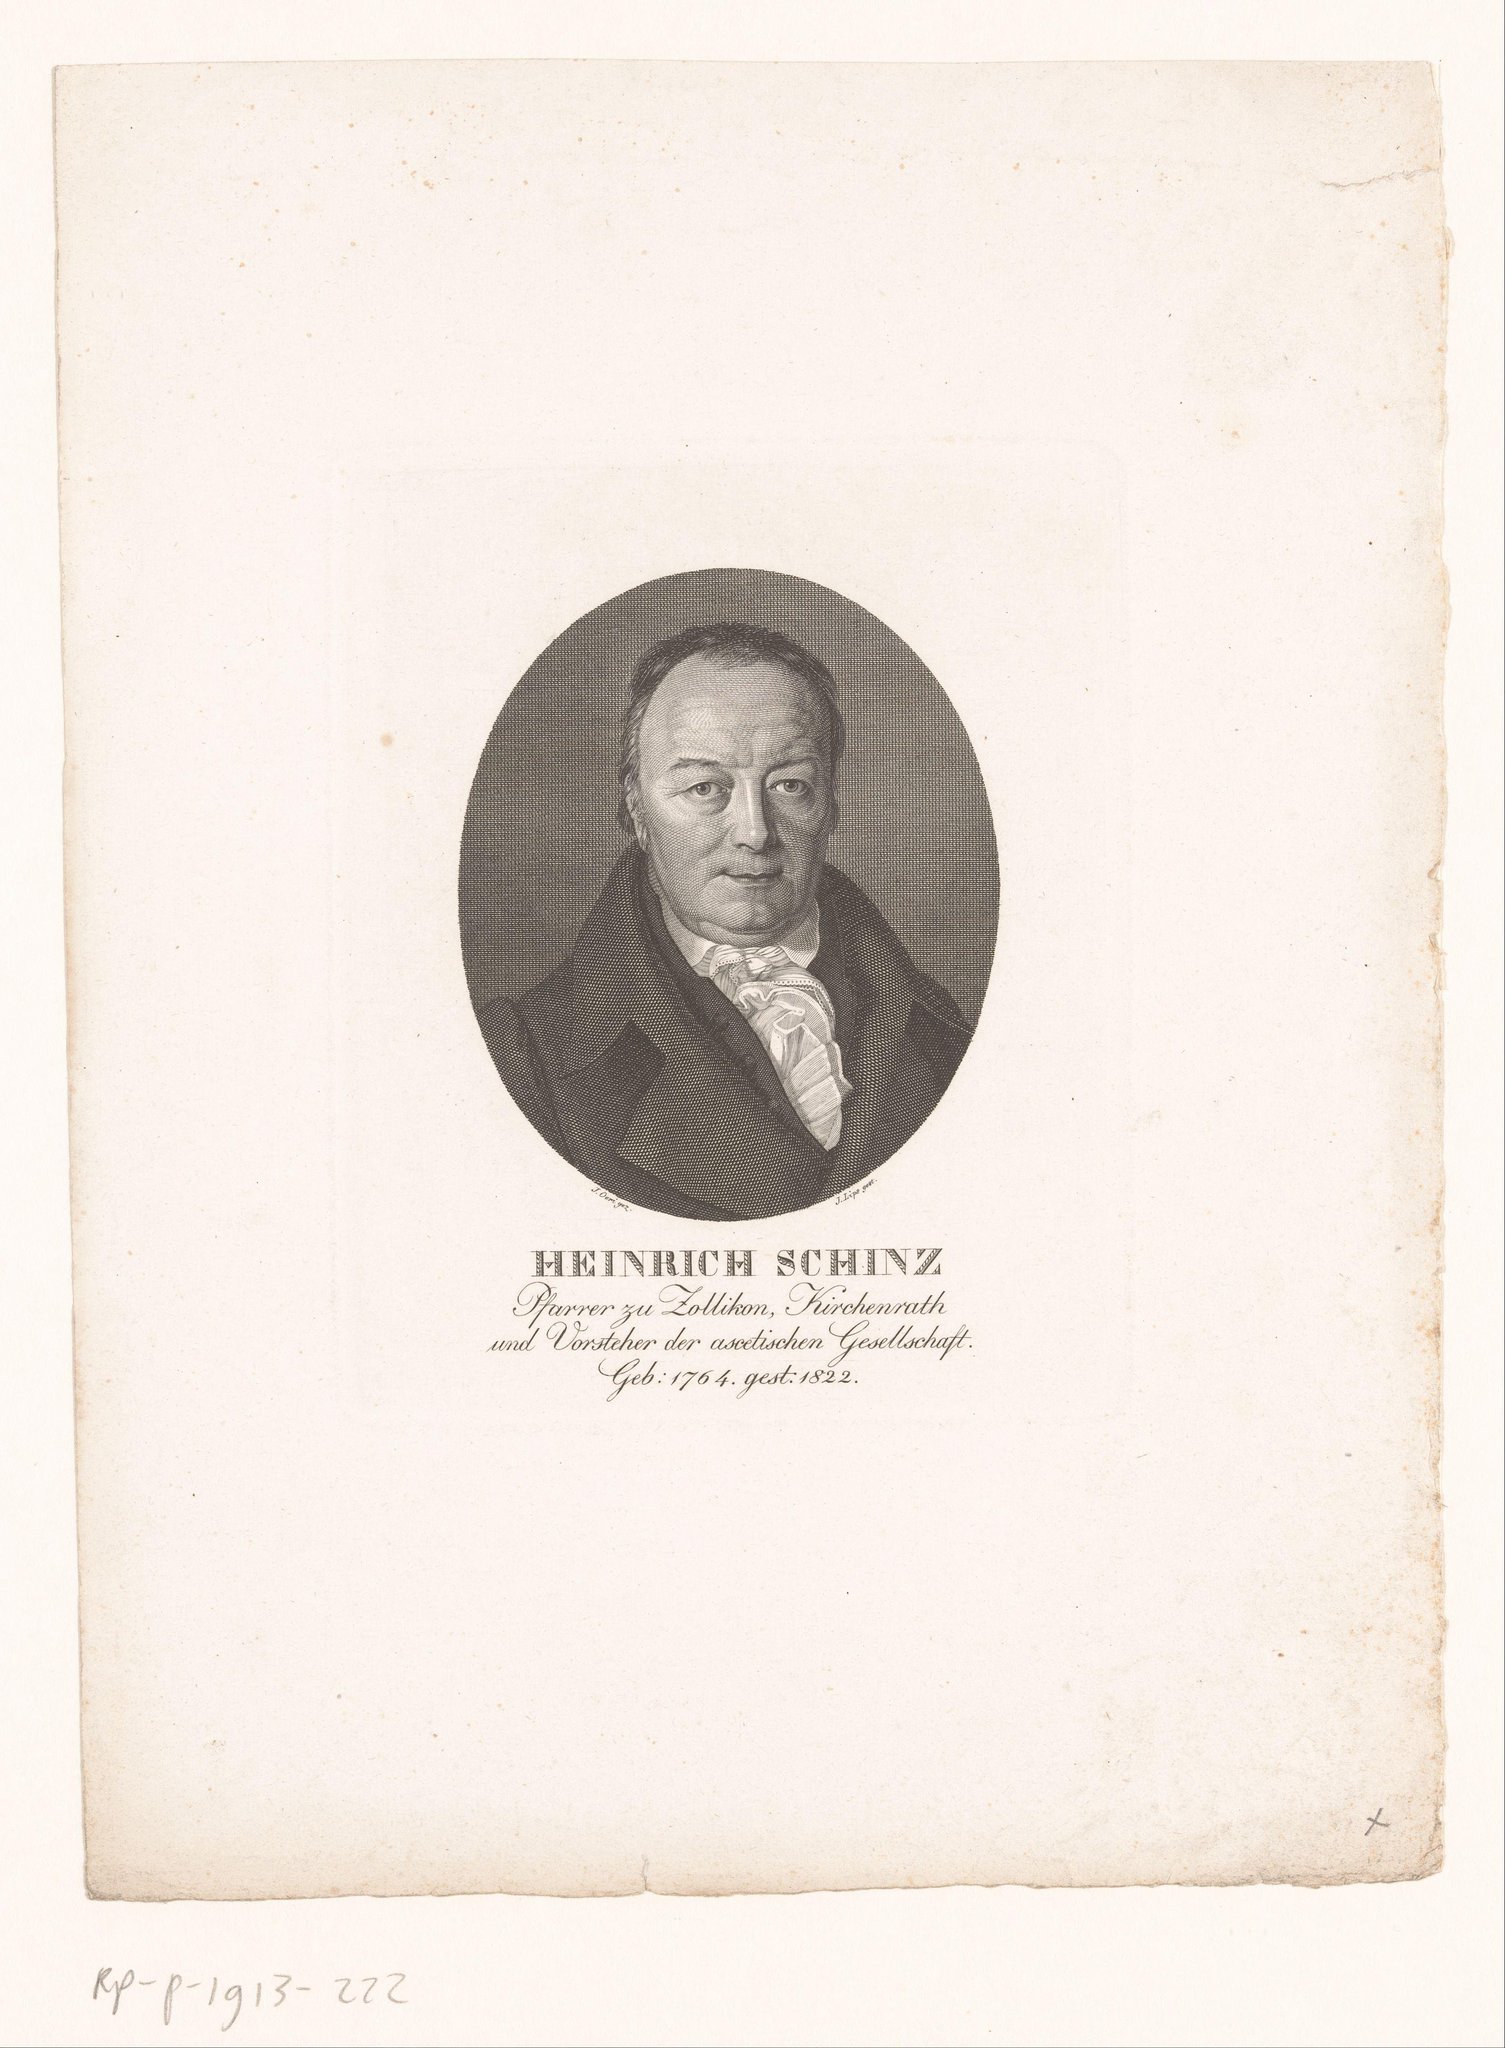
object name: print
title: Portret van Johann Heinrich Schinz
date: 1822-1831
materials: paper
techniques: engraving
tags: theologian, historical persons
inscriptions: collector's mark: Lugt 2228